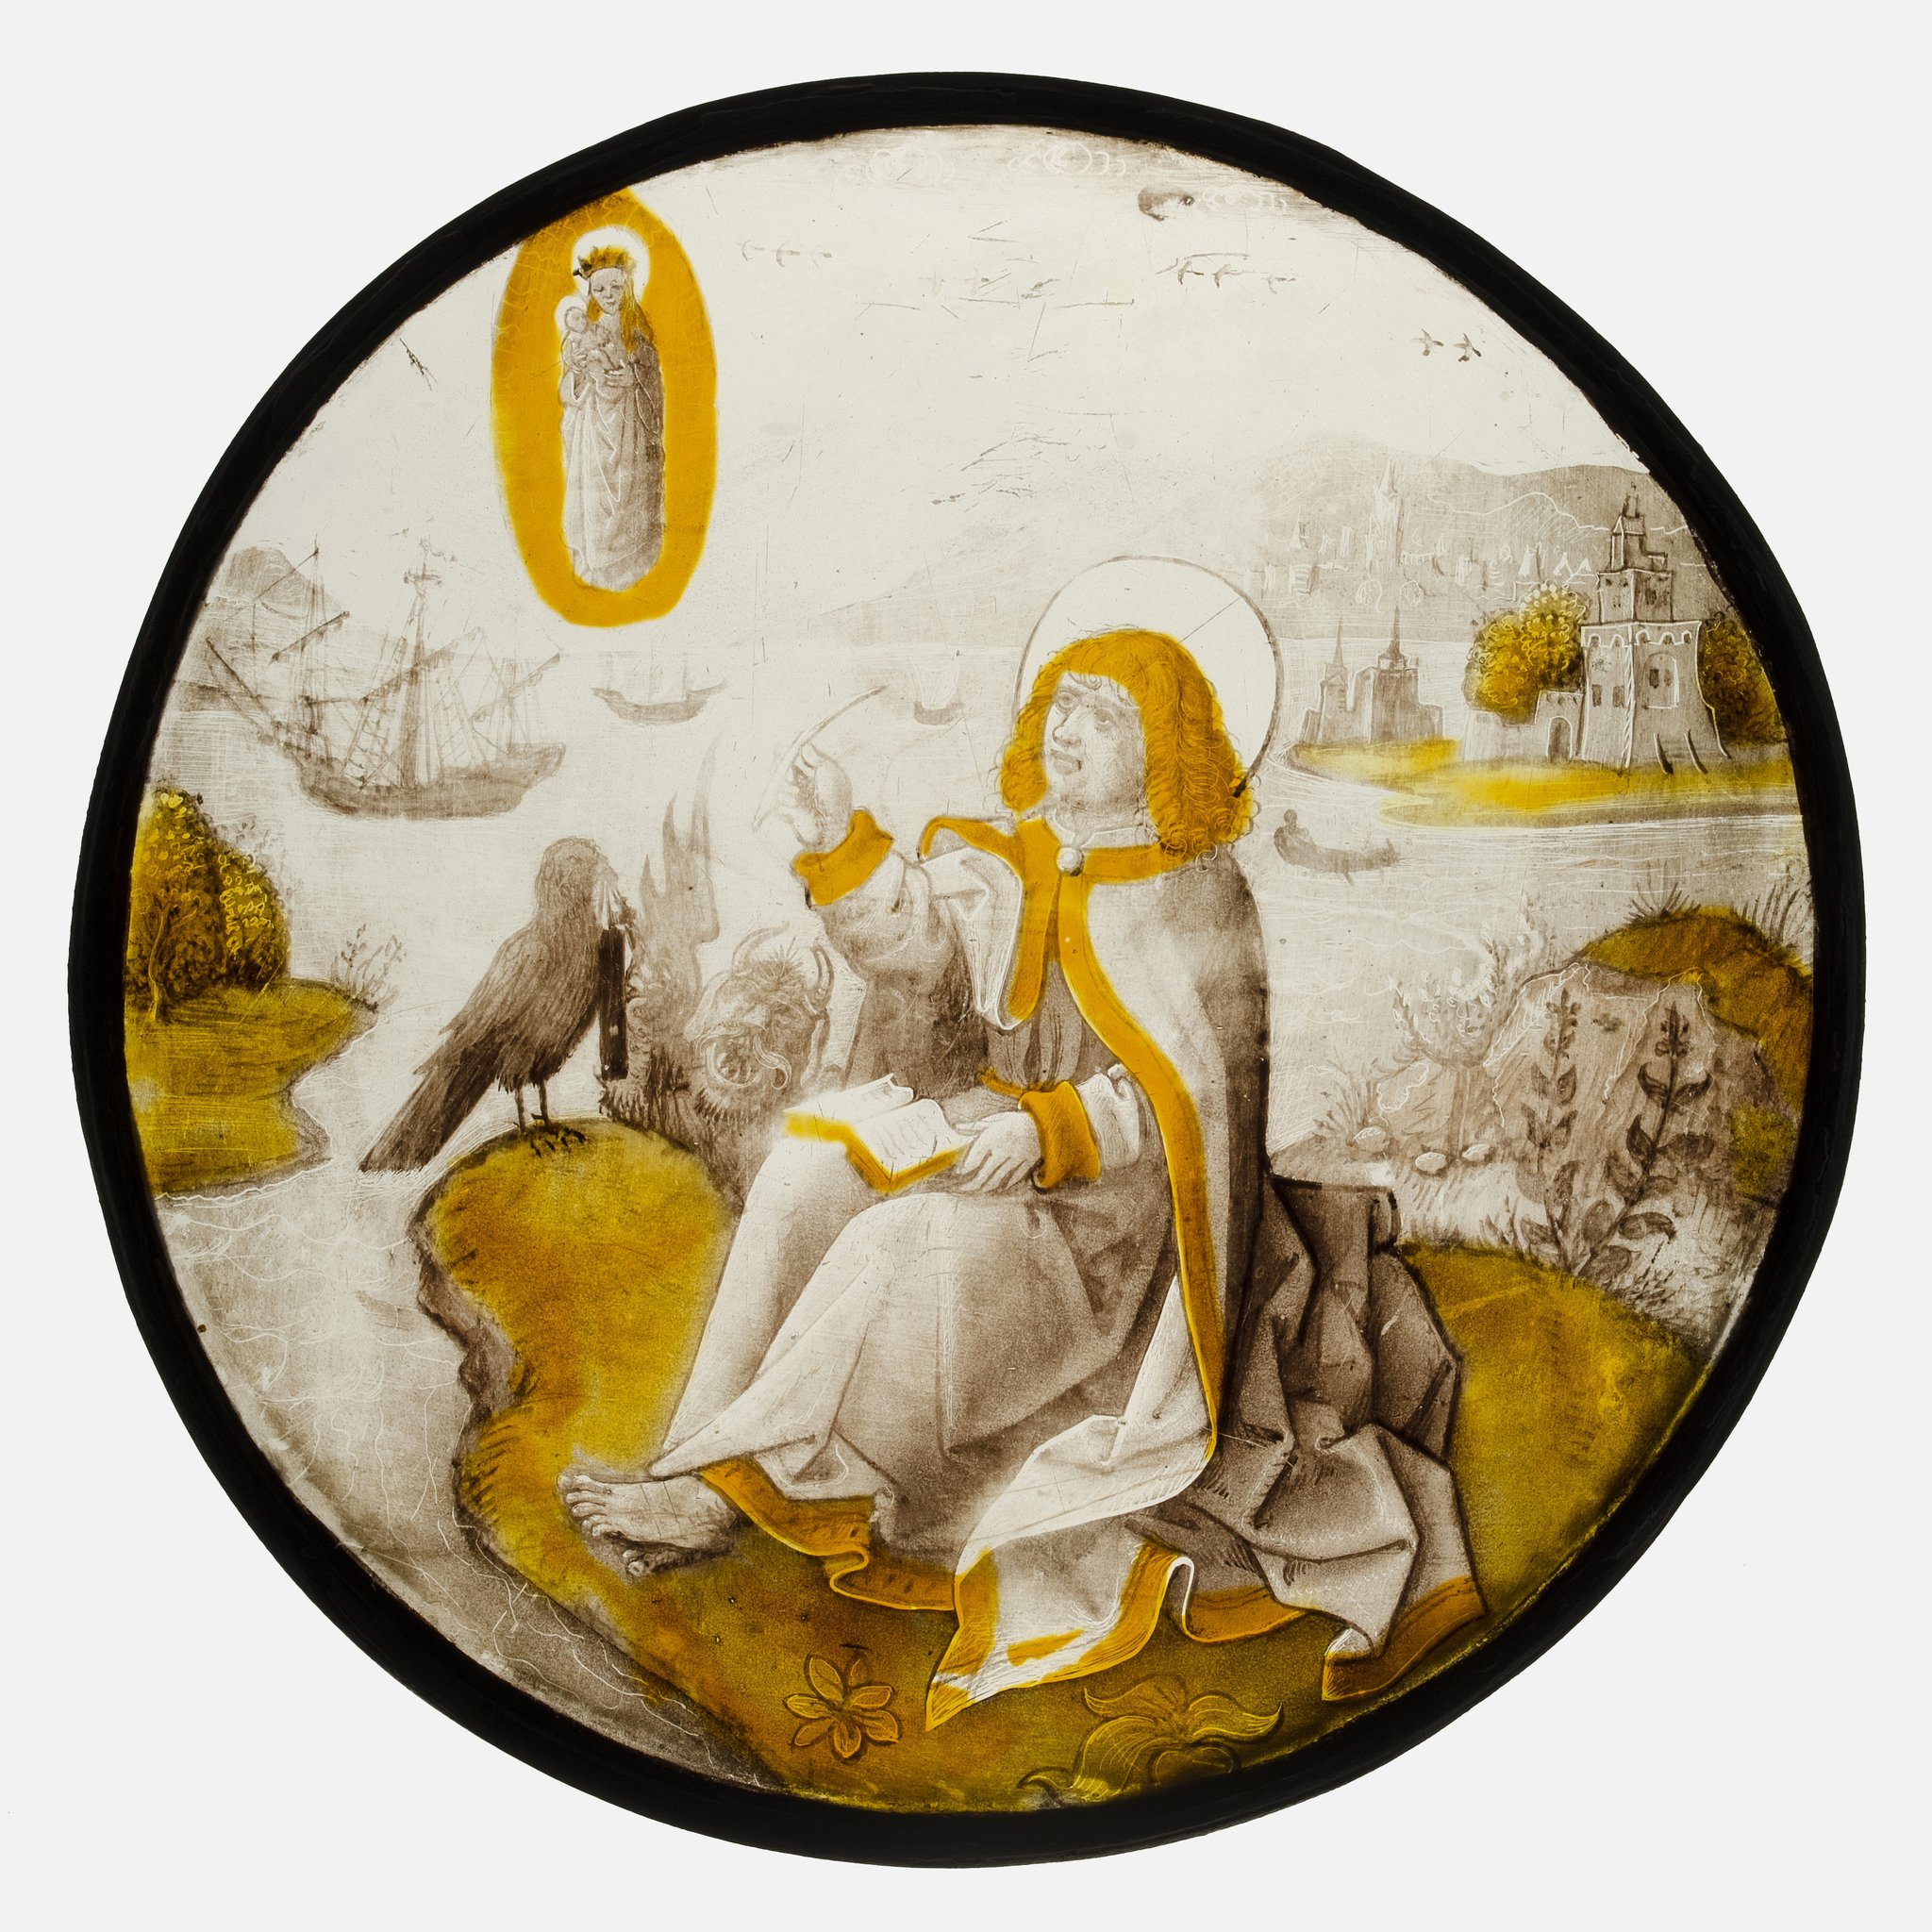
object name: roundel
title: Roundel with Saint John on Patmos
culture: south netherlandish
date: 1510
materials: glass, paint, pigment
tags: birds,saint john the evangelist,ships